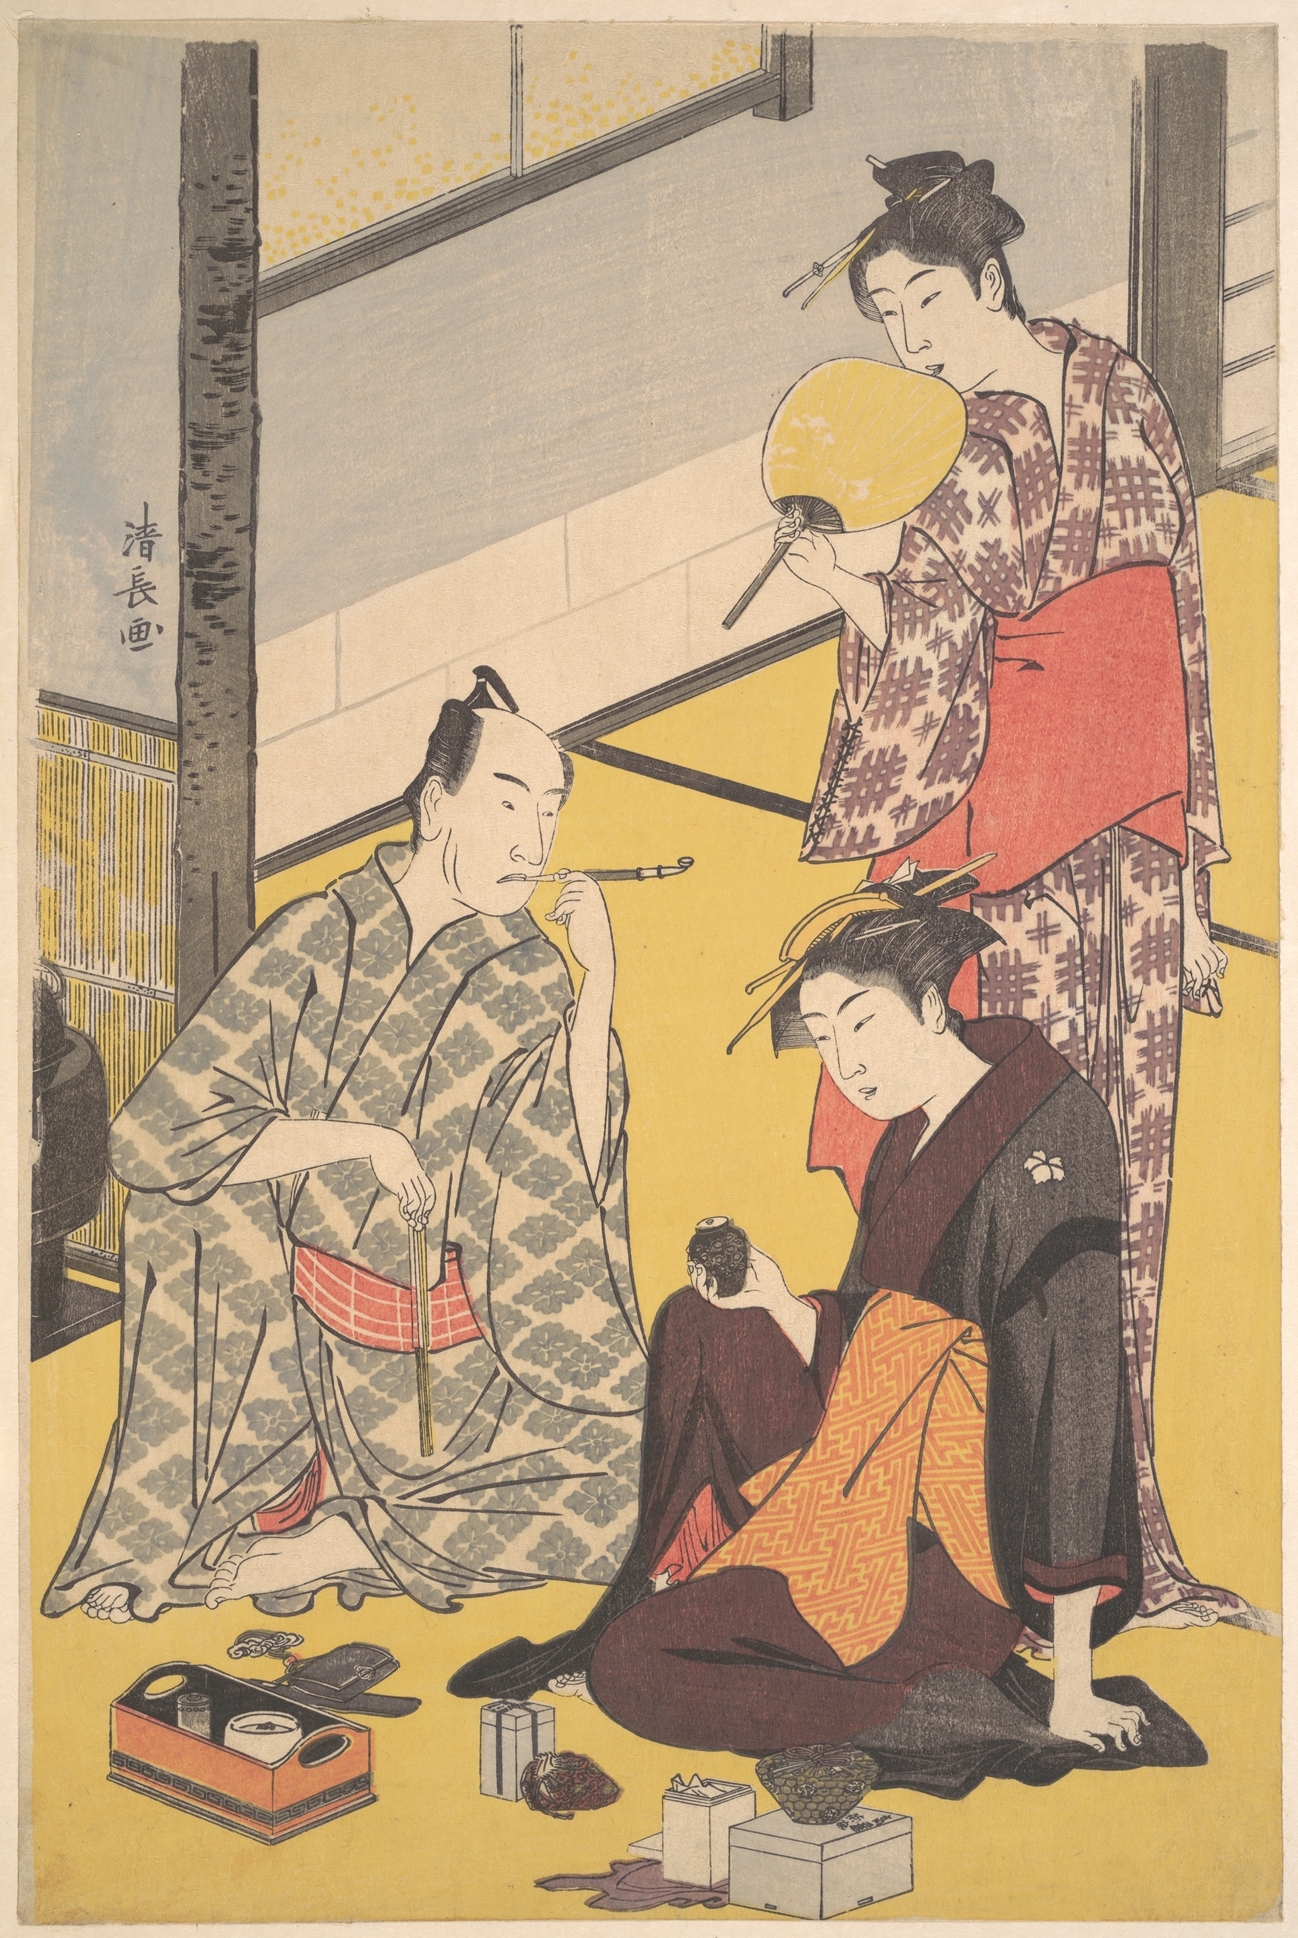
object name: print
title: The Kabuki Actor Matsumoto Kōshirō IV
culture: japanese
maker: torii kiyonaga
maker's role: artist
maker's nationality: japanese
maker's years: 1752-1815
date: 1783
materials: ink, paper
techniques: woodblock print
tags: fans,men,women,actors